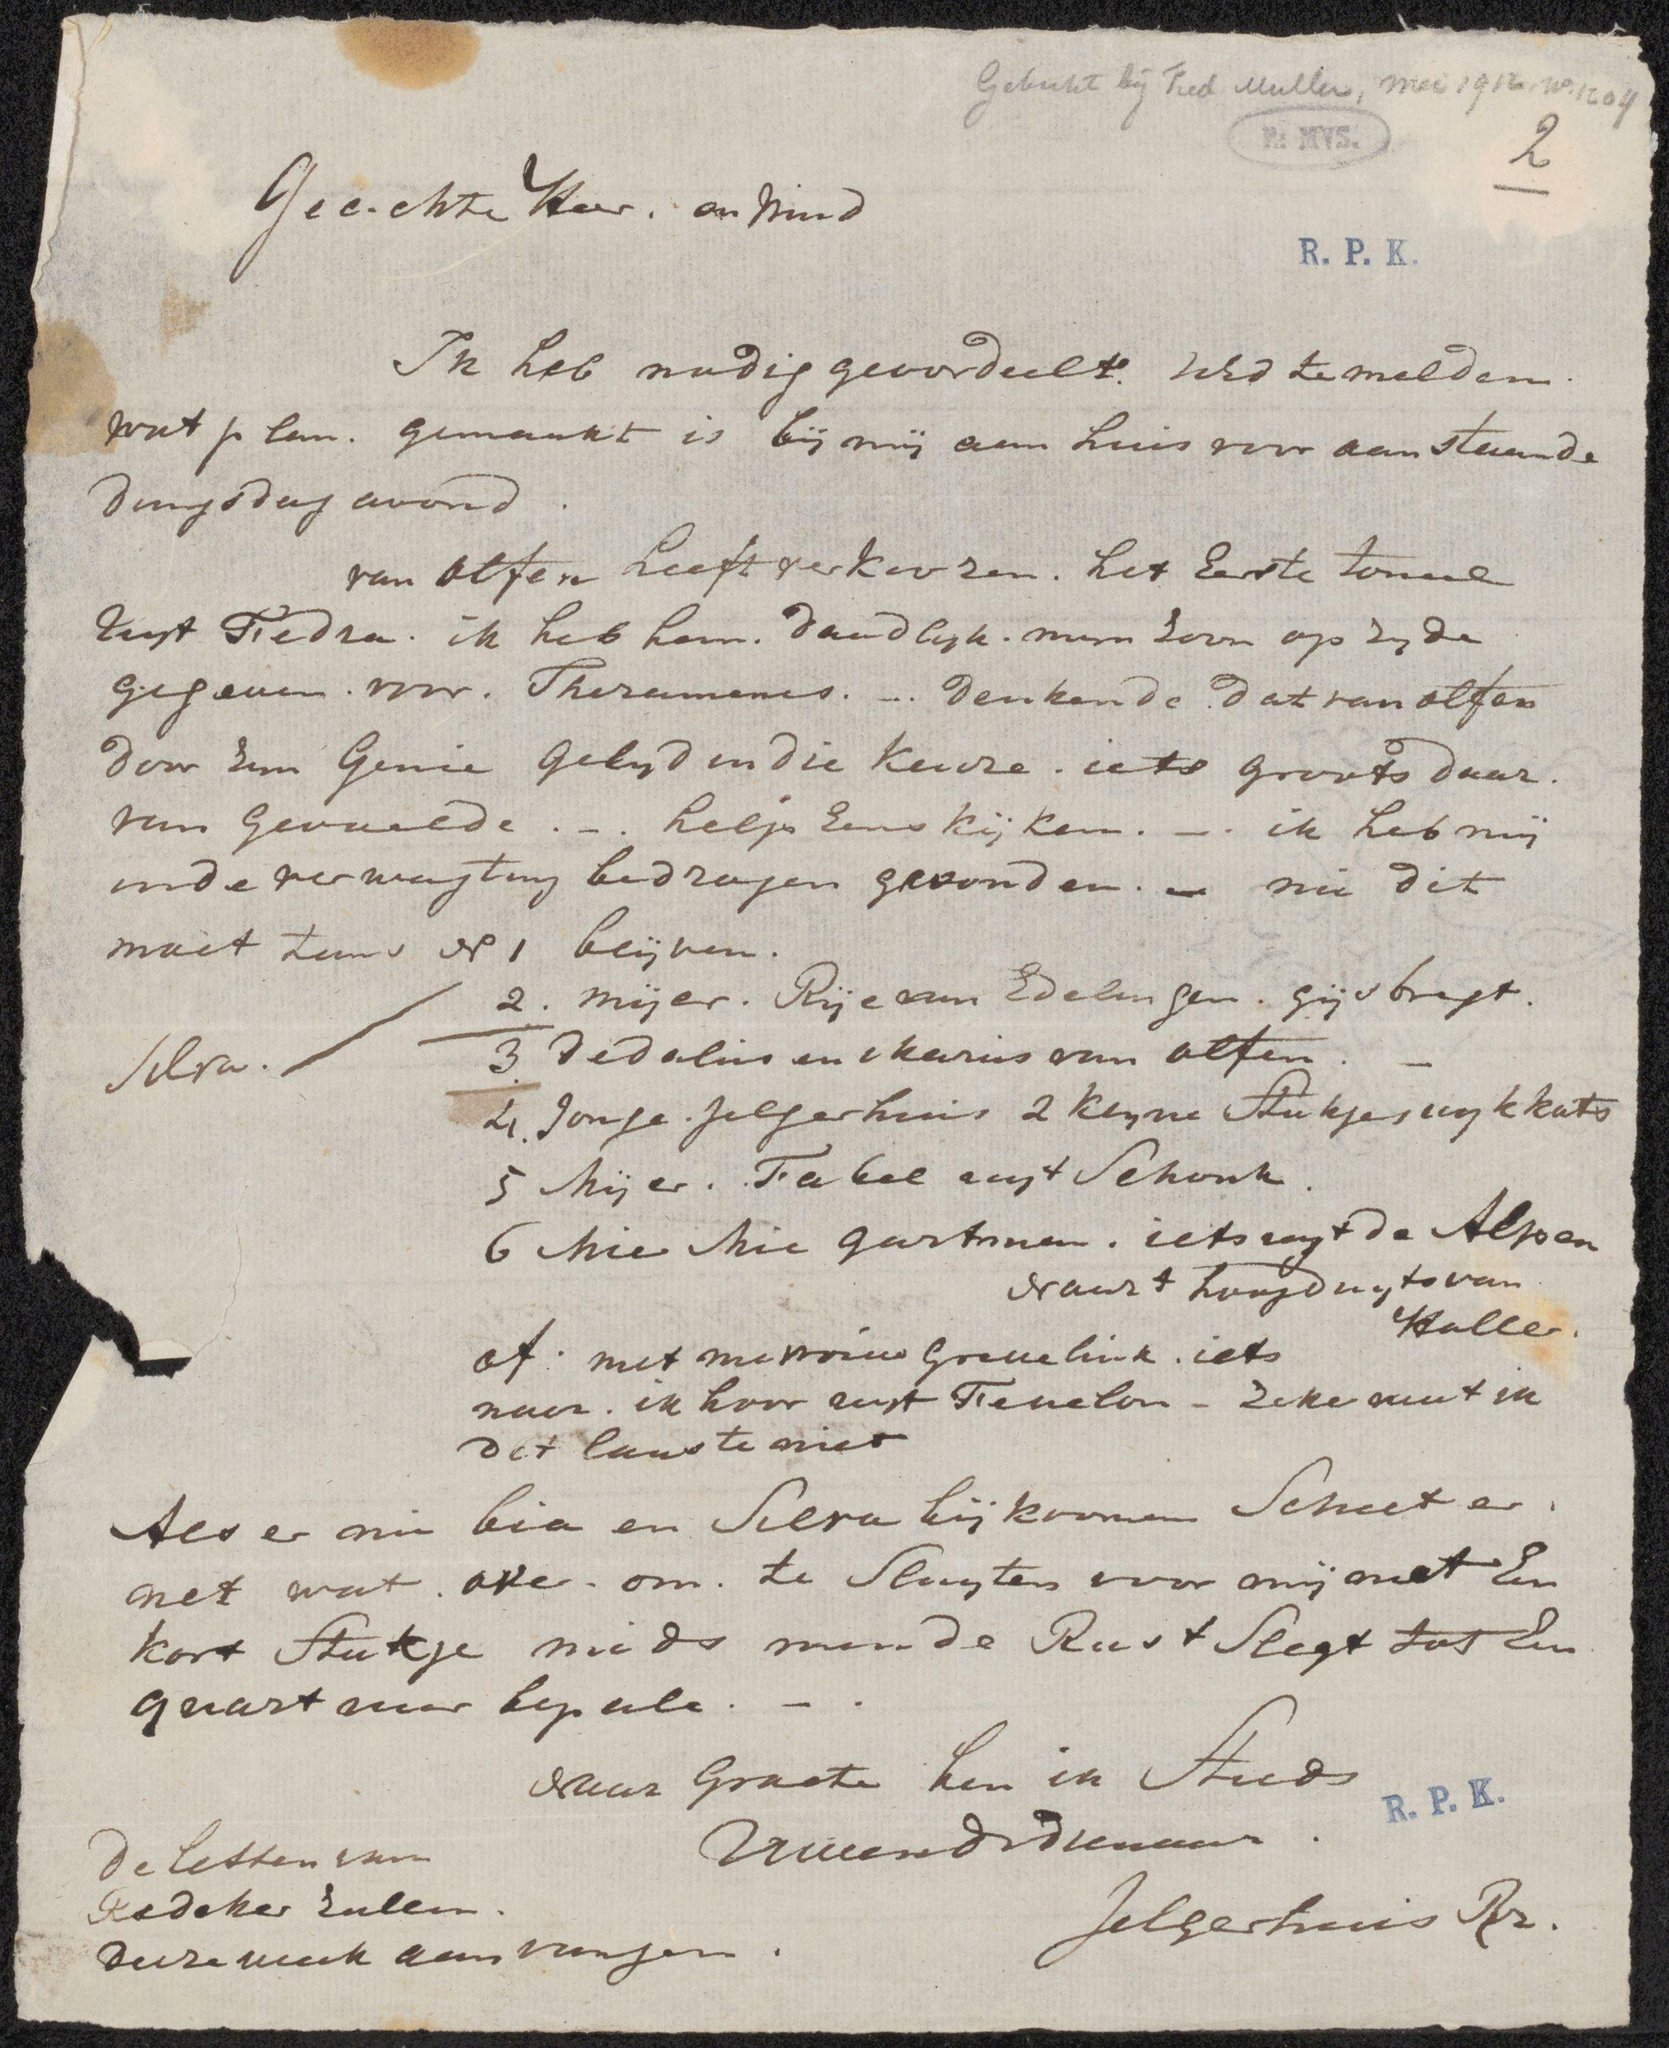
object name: letter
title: Brief aan de heer De Bruine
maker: johannes jelgerhuis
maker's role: draughtsman, painter, print maker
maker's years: 1770-1836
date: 1780-1836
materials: ink, paper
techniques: pen, writing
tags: the arts of the stage: ballet, theatre, musical drama, motion picture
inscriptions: collector's mark: Lugt 2233, watermark, collector's mark: Lugt 2228a